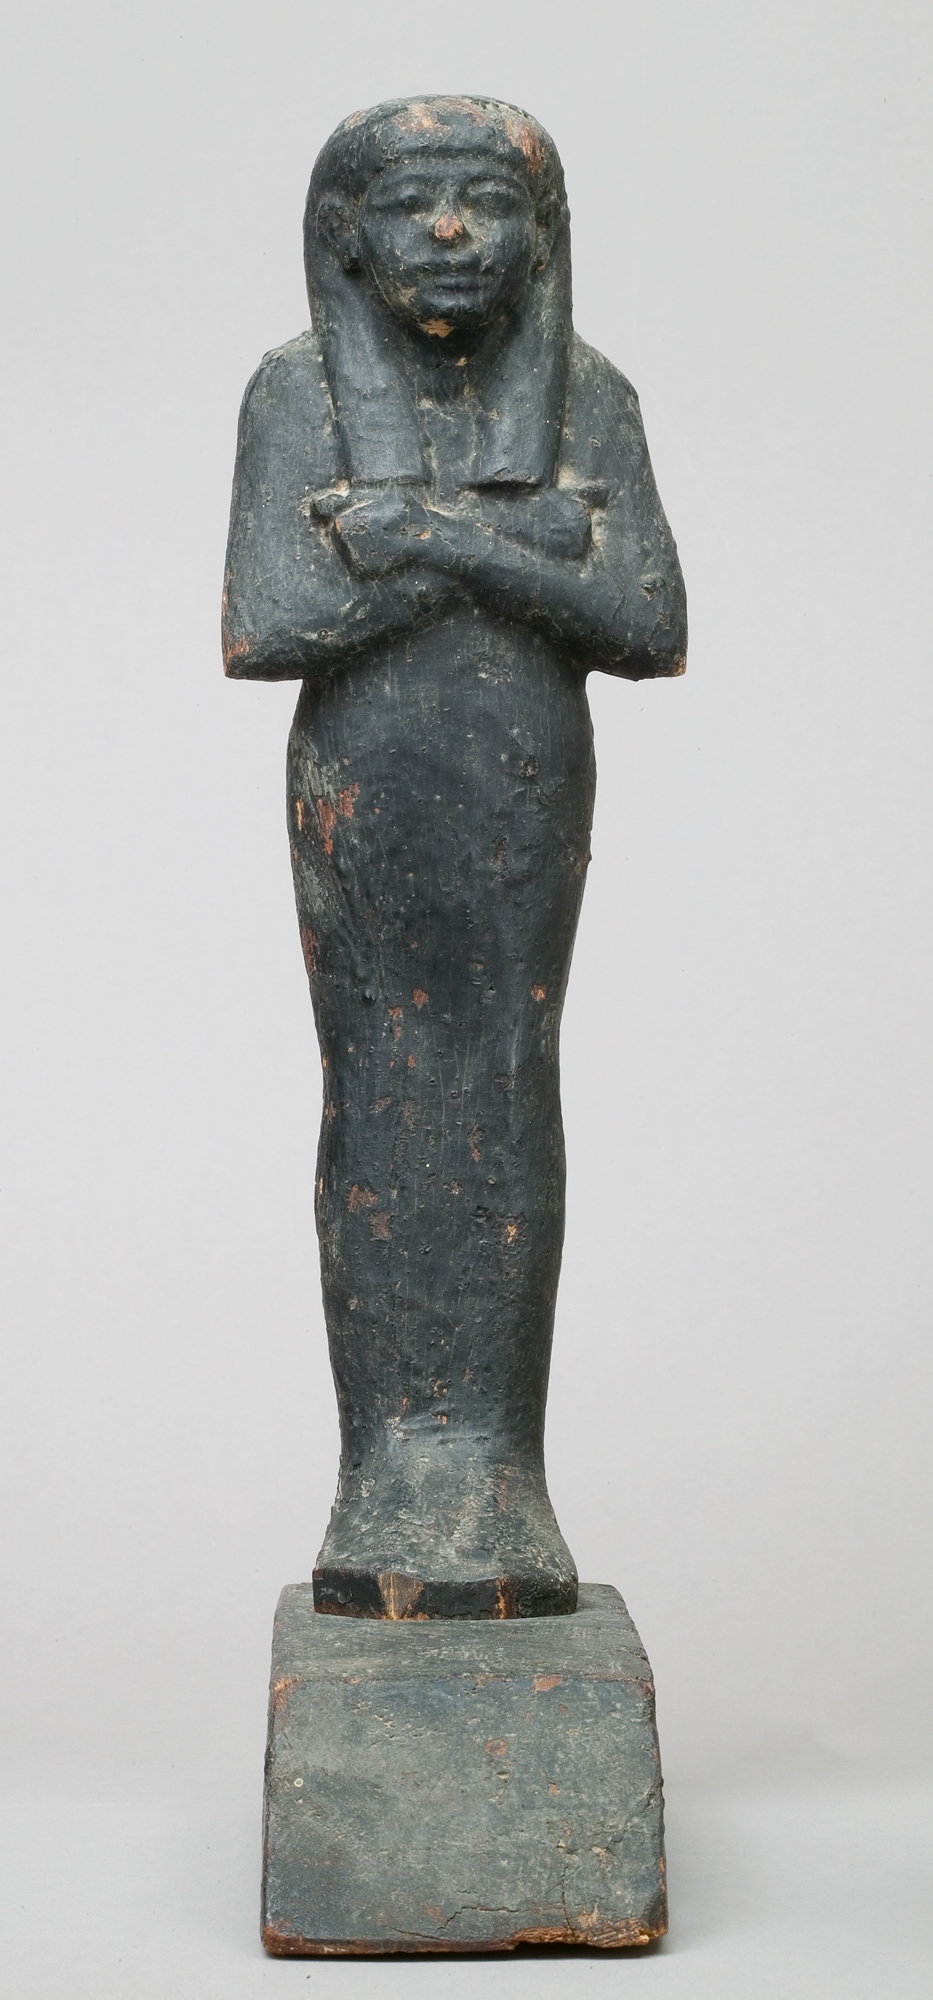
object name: funerary figure, magical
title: Magical Funerary Figure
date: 1550-1186 BCE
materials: wood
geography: upper egypt, thebes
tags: men